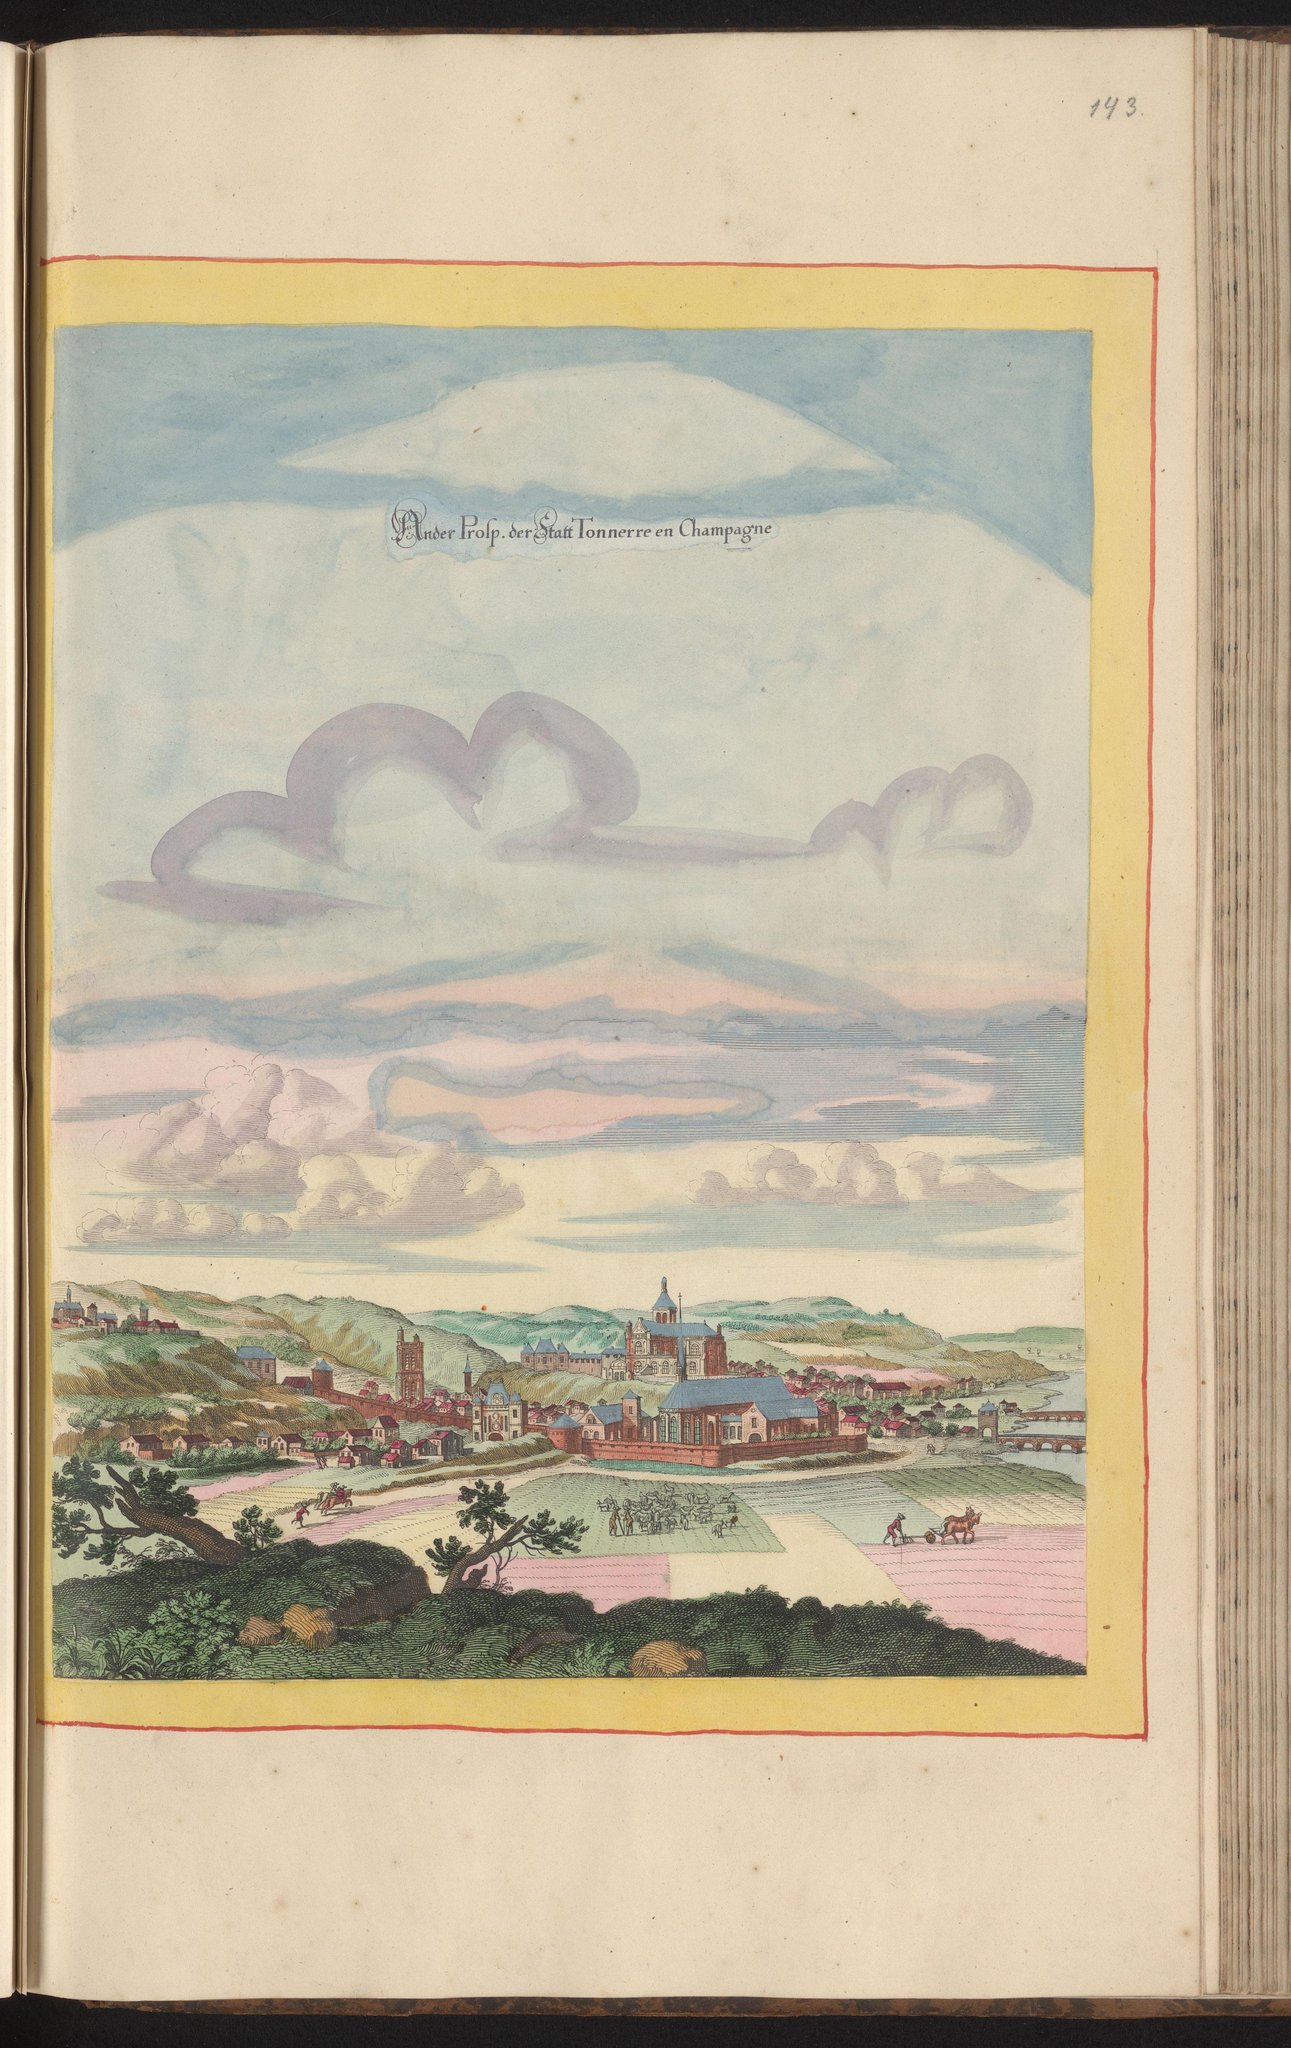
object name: album leaf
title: Gezicht op Tonnerre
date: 1656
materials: paper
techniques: engraving, etching, hand coloring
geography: the hague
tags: city-view in general; 'veduta'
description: Prent uit: Zeiller, Martin. Topographia Galliae. 13 dln. Frankfurt: Caspar Merian, 1656, dl. 3, na p. 32.